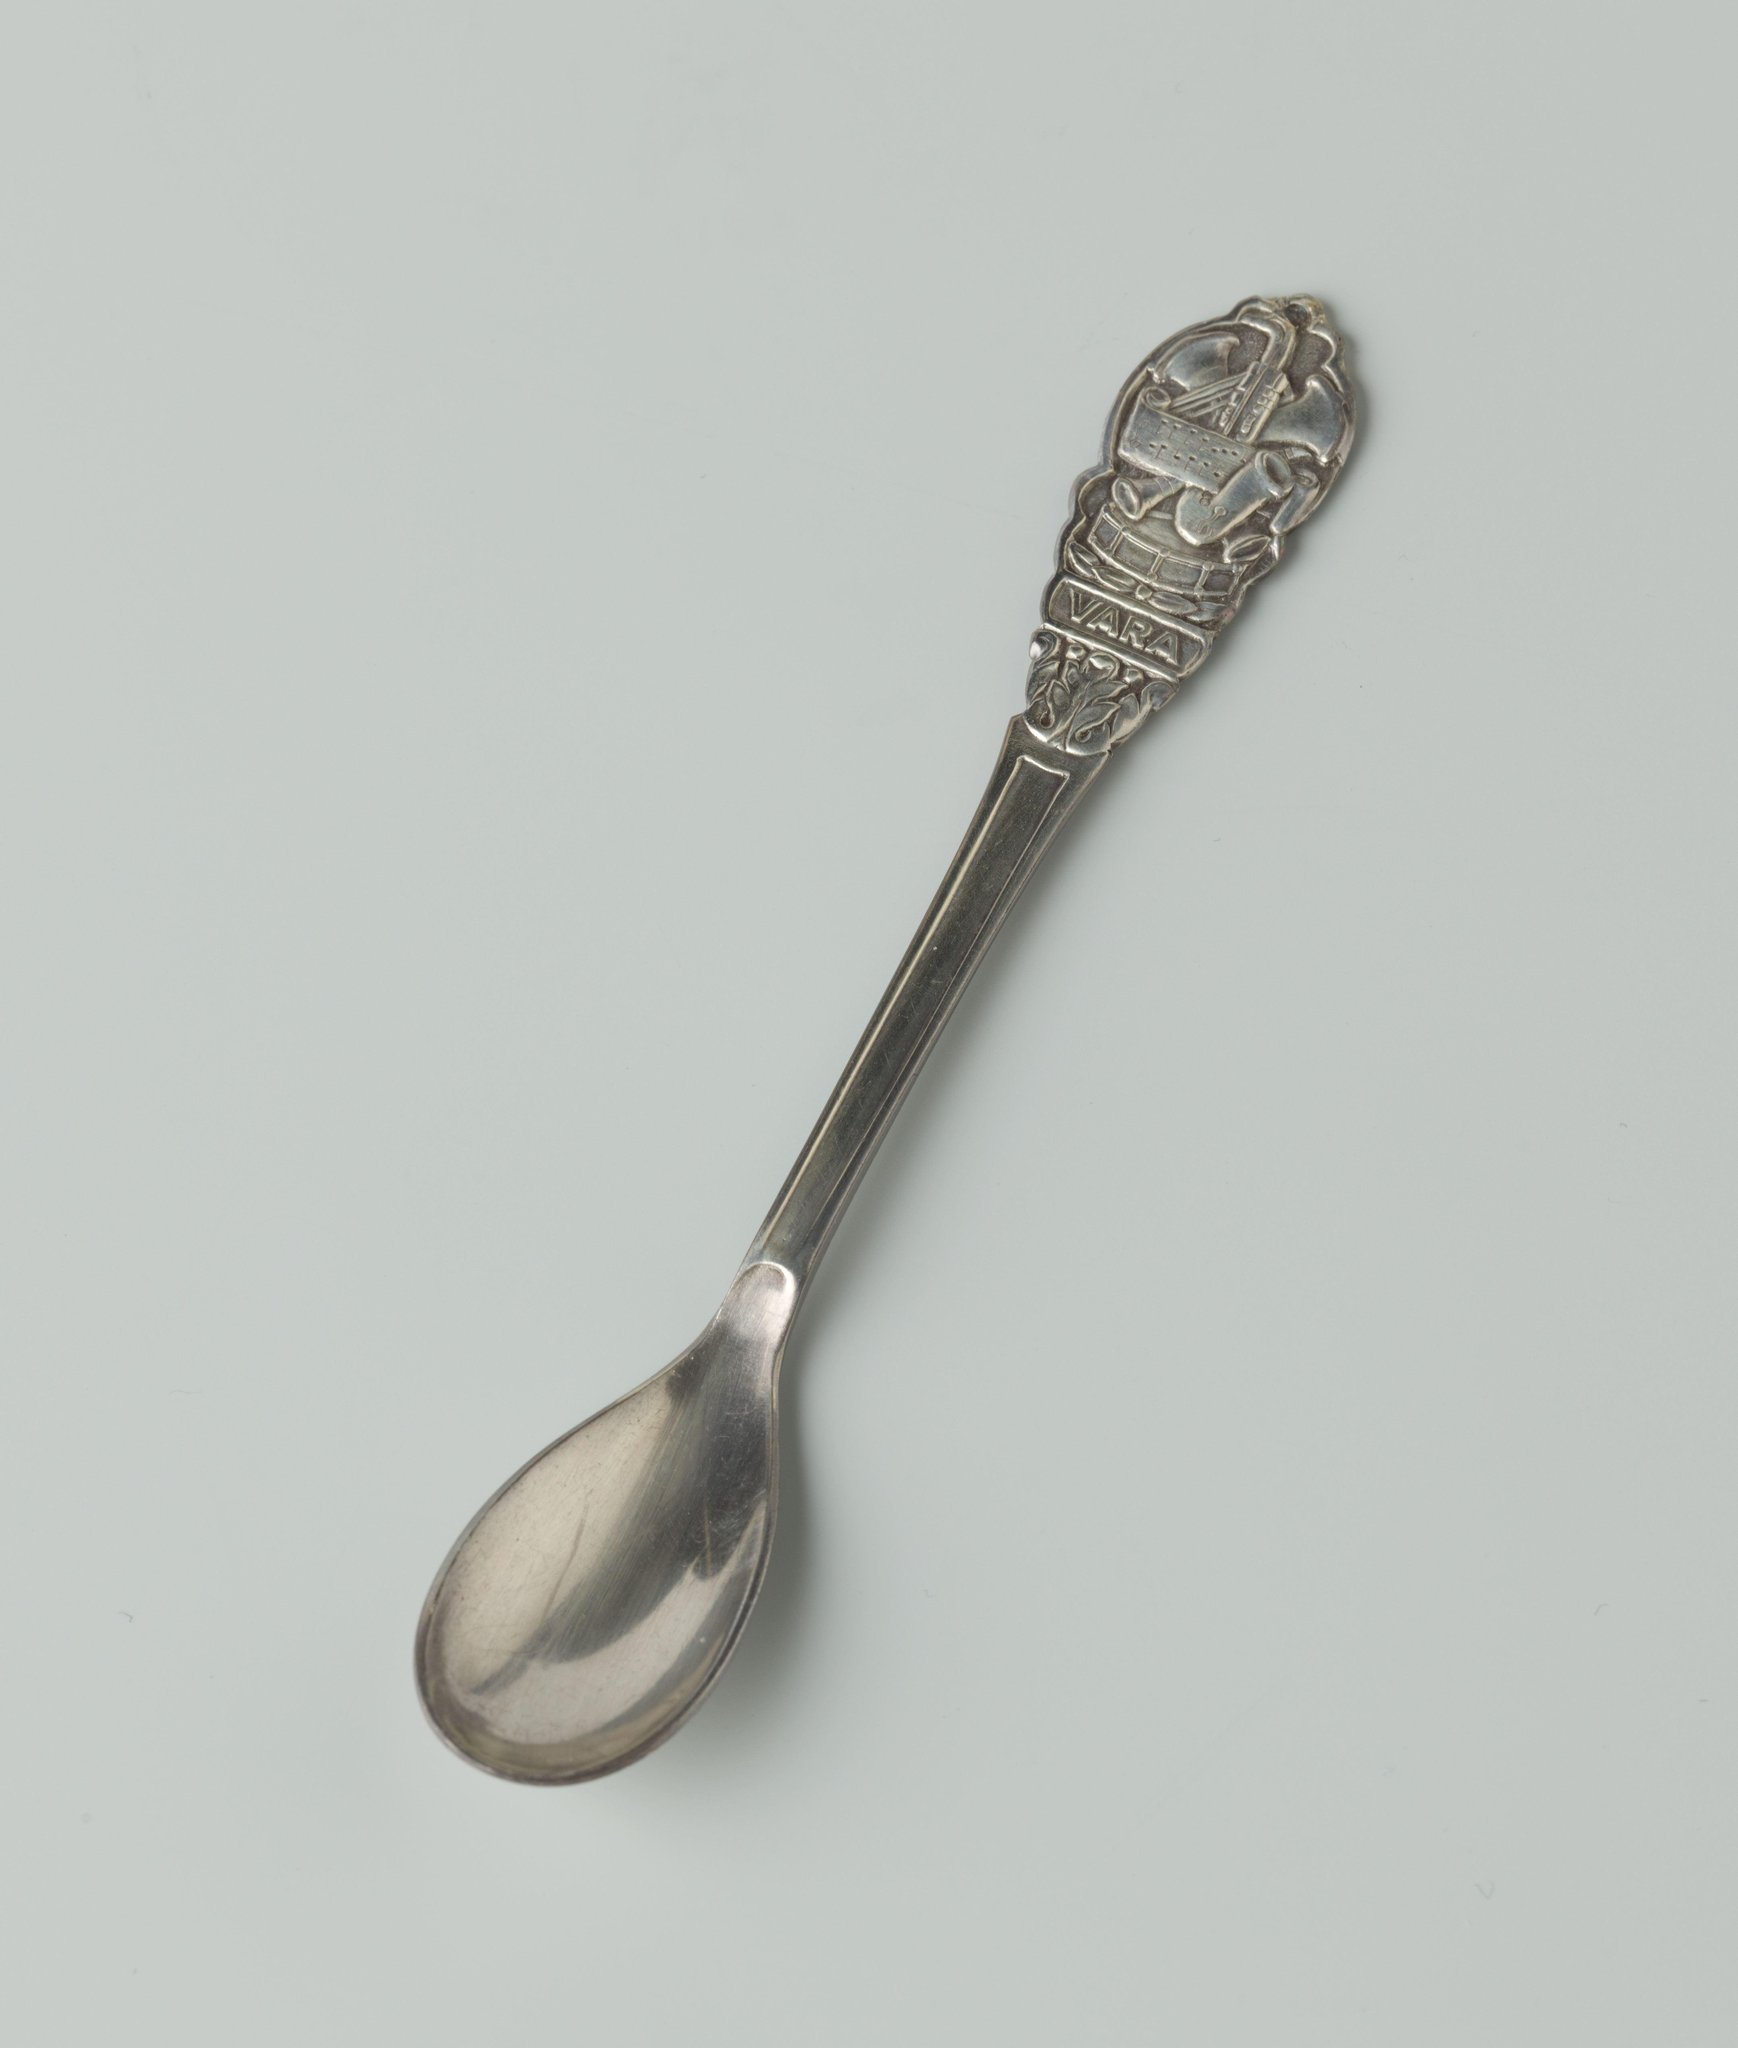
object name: teaspoon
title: VARA theelepeltje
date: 1900-1982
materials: metal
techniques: casting, silvering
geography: zeist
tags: netherlands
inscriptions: mark: ‘H SOLA 90’, inscription: ‘VARA’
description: In the 1920s the various Dutch religious and political streams established separate radio organisations. The Protestant NCRV started in 1924, the Catholic KRO and the Socialist VARA in 1925, the Nonconformist Protestant VPRO in 1926 and the Liberal AVRO in 1927. All these organisations had one thing in common: lack of funds. There were constant money-raising activities and membership drives.